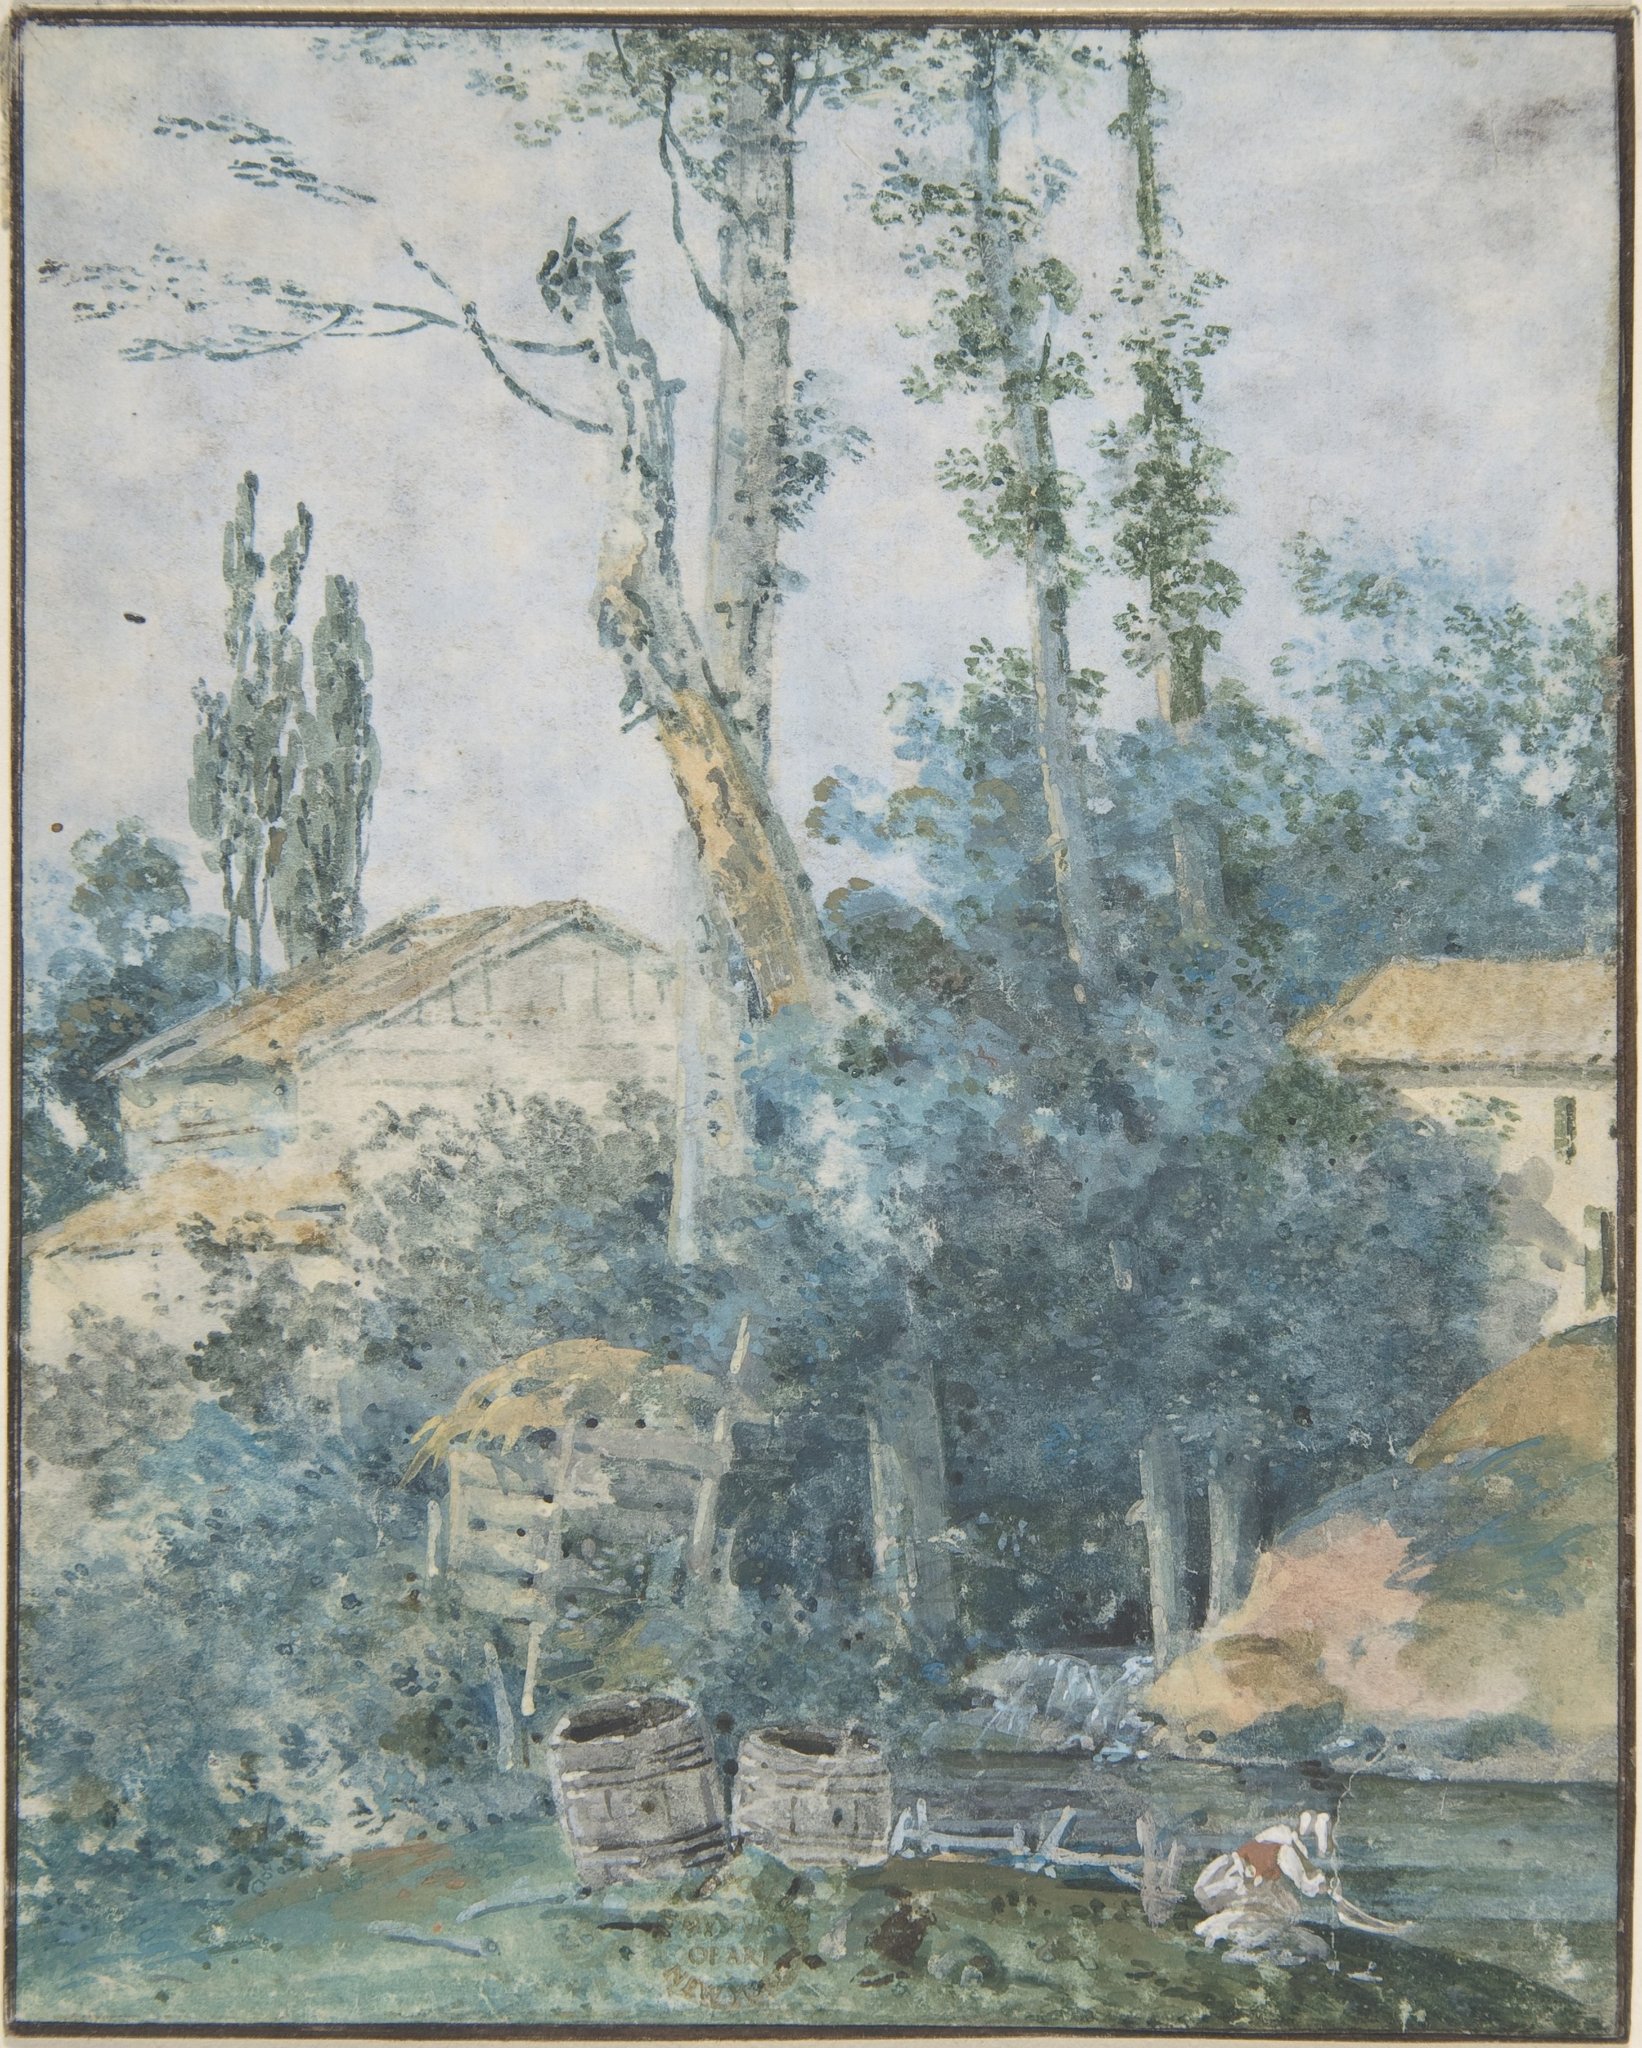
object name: drawing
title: Rustic Scene – A Woman Washing Clothes in a Stream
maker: anonymous, french, 18th century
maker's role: artist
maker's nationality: french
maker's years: 1700-1800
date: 1701-1800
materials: gouache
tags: women,landscapes,washing